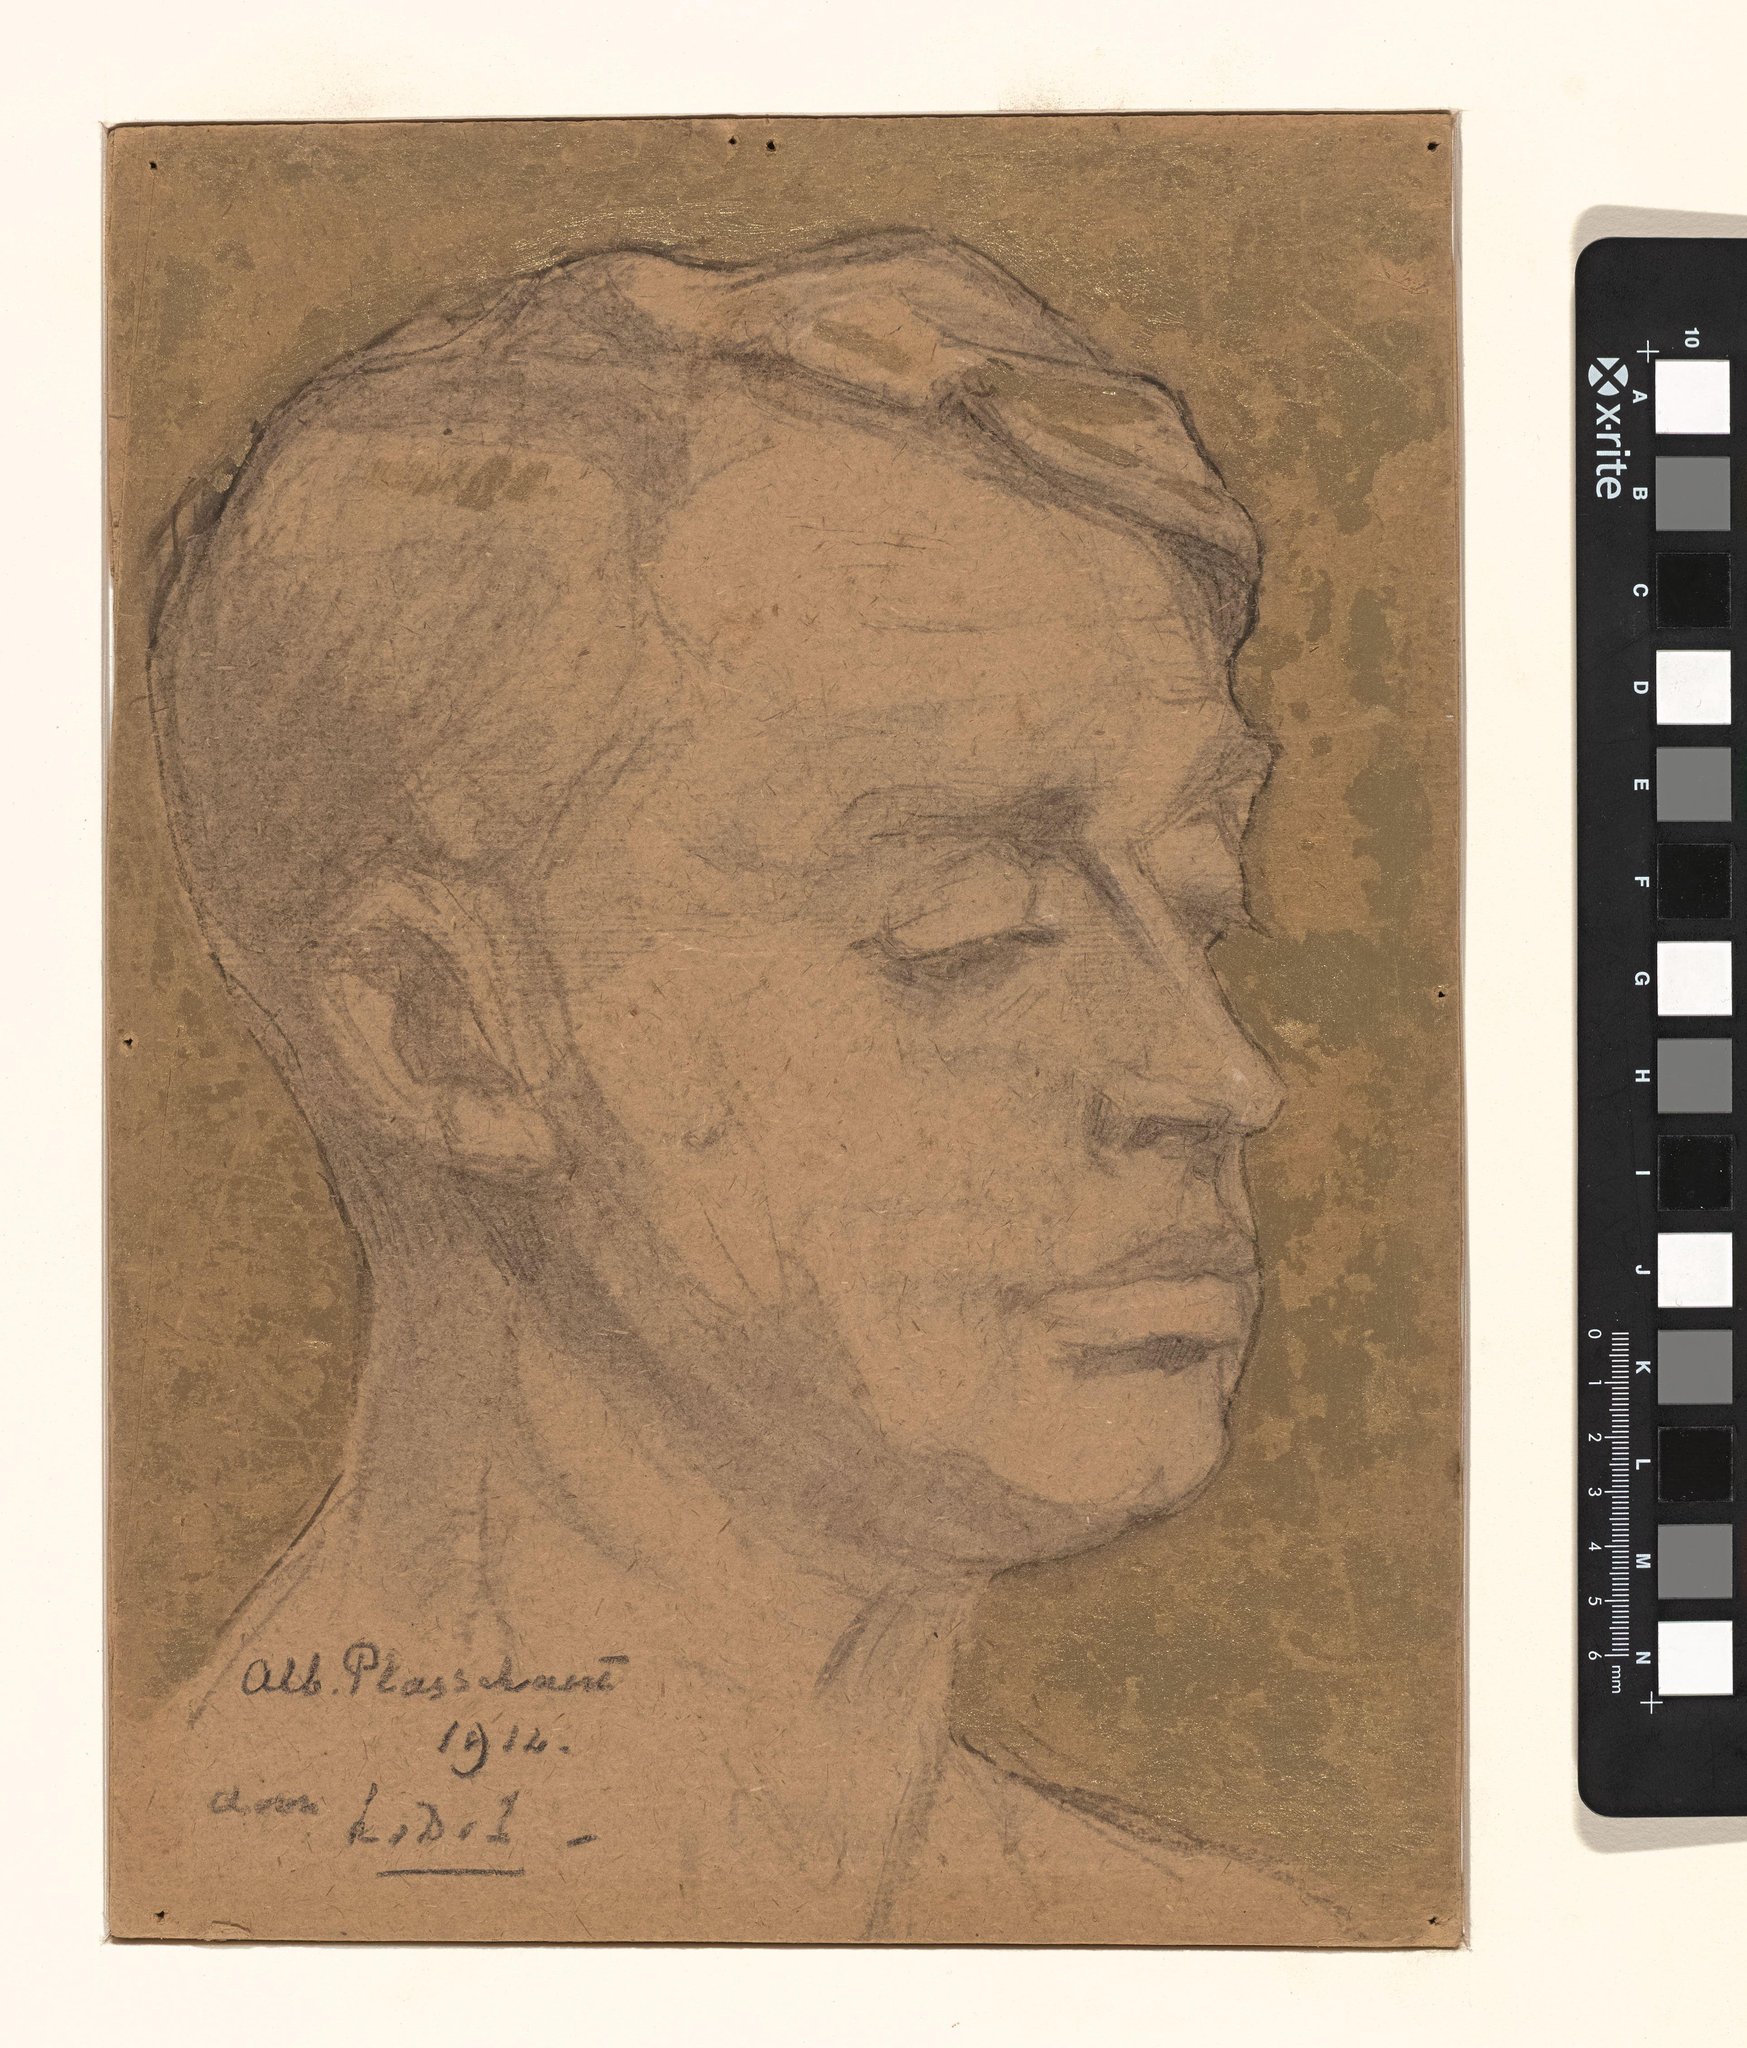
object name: drawing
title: Portret van Albert Plasschaert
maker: lucie van dam van isselt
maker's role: draughtsman, print maker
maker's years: 1871-1949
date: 1914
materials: cardboard, chalk, charcoal, paint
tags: delft, albert plasschaert, historical persons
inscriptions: date: ‘1914’